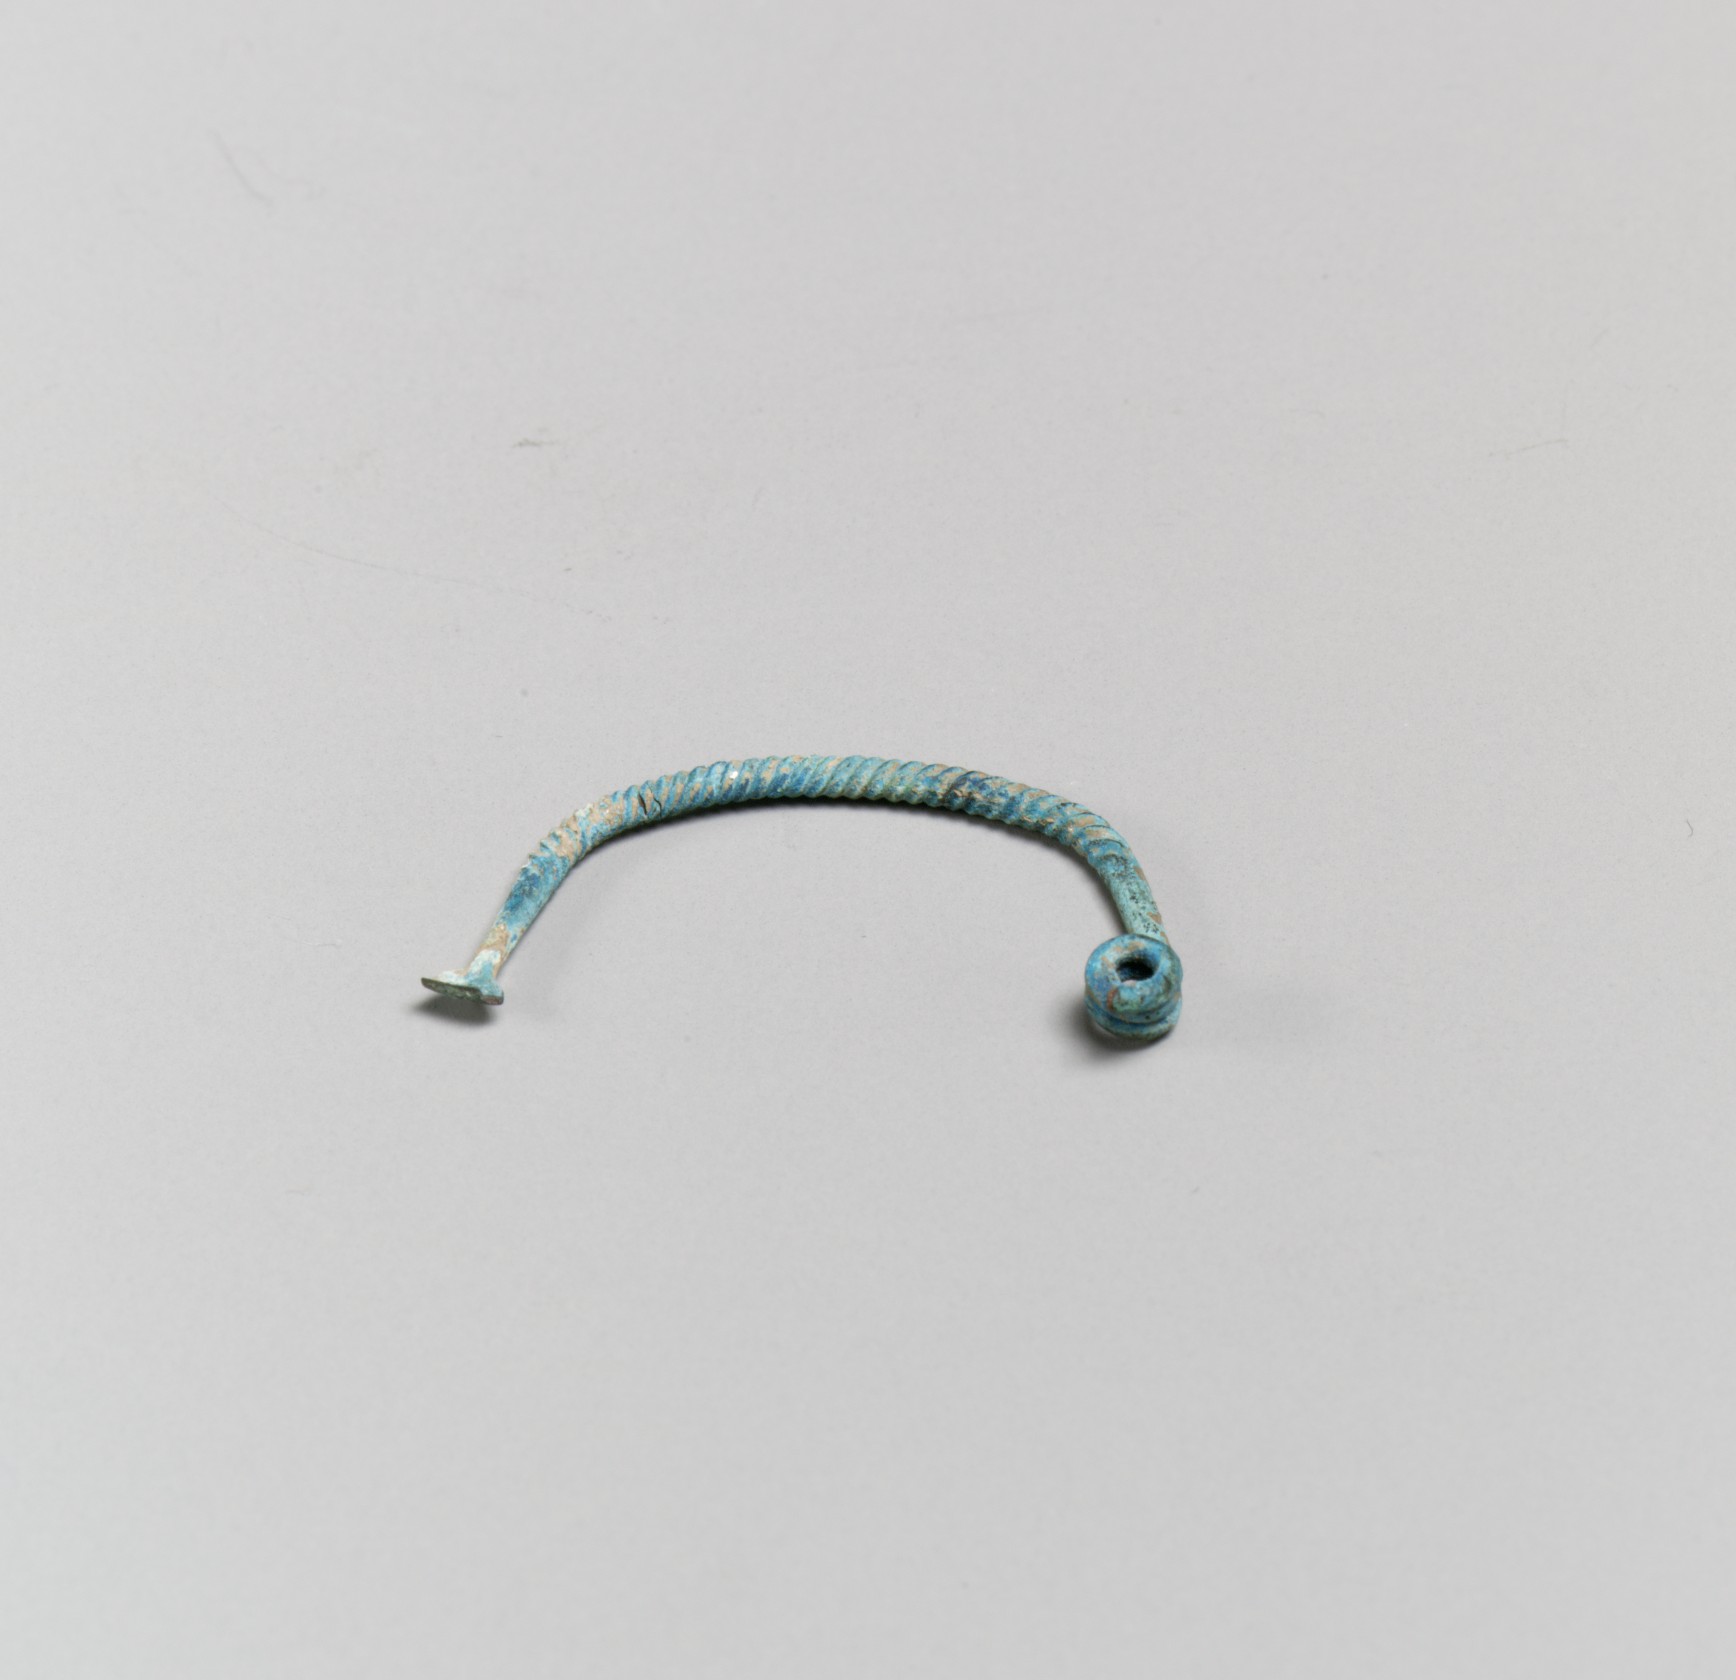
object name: fibula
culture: italic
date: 1600-1100 BCE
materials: bronze